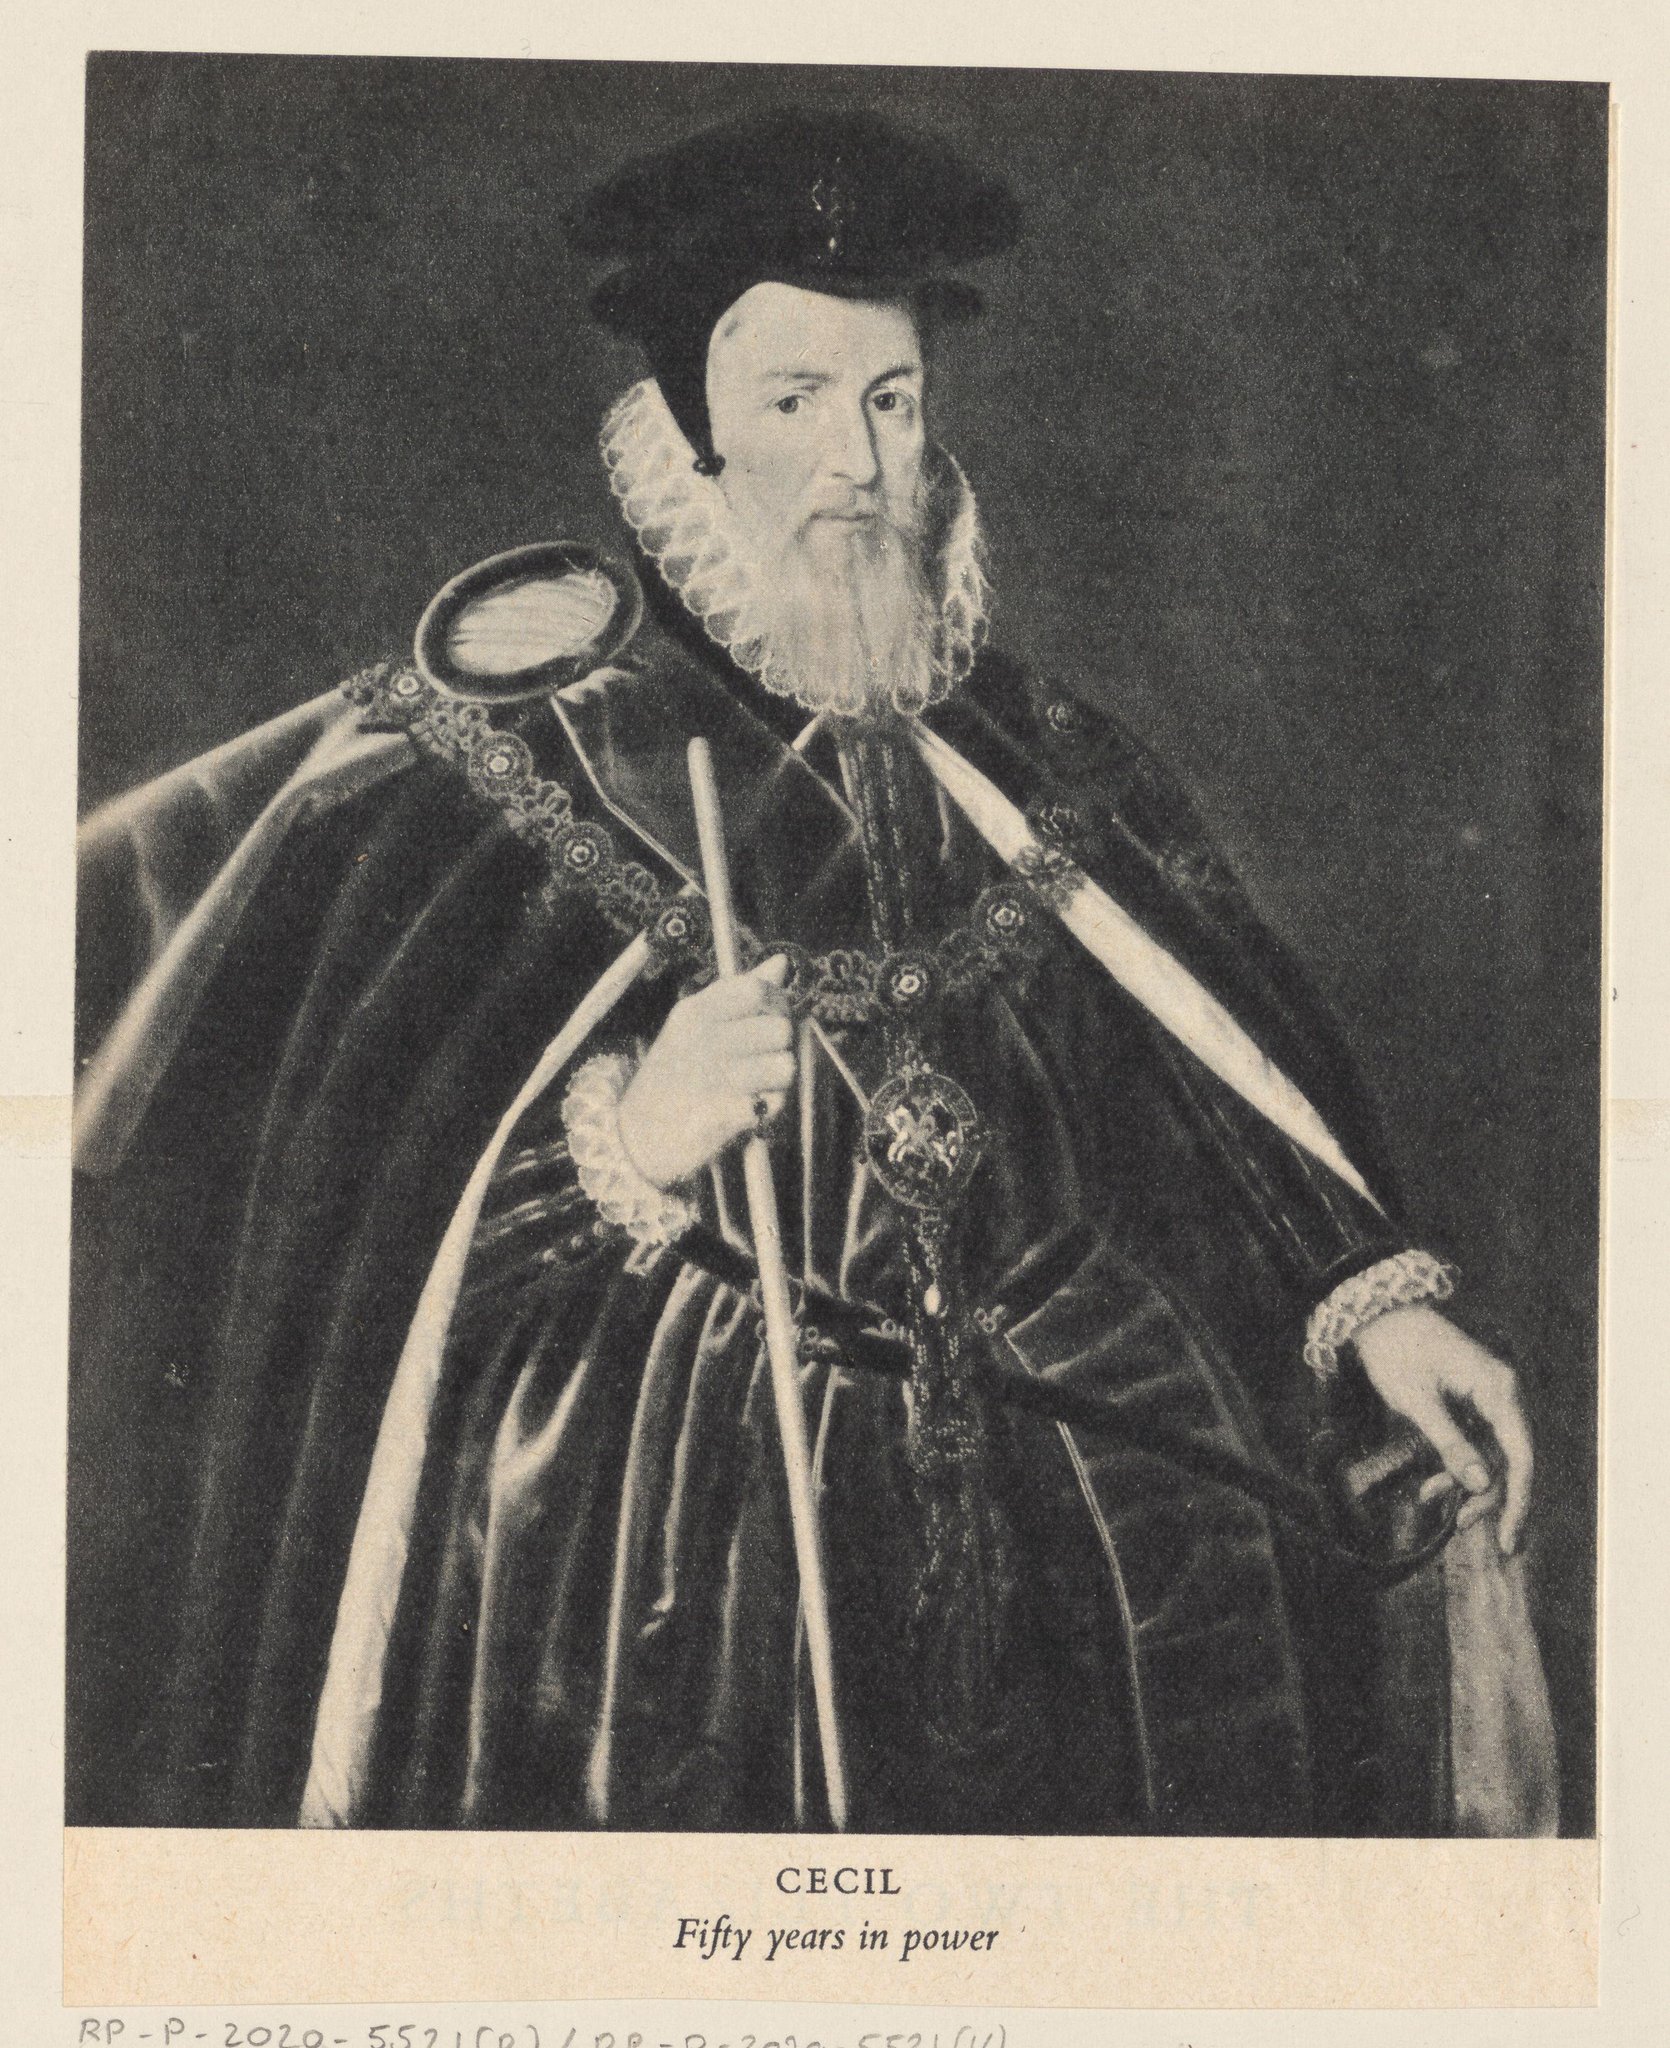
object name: photomechanical print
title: Portret van William Cecil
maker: Anonymous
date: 1952-1970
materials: paper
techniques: rotogravure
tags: official; civil servant; functionary (in general), historical persons